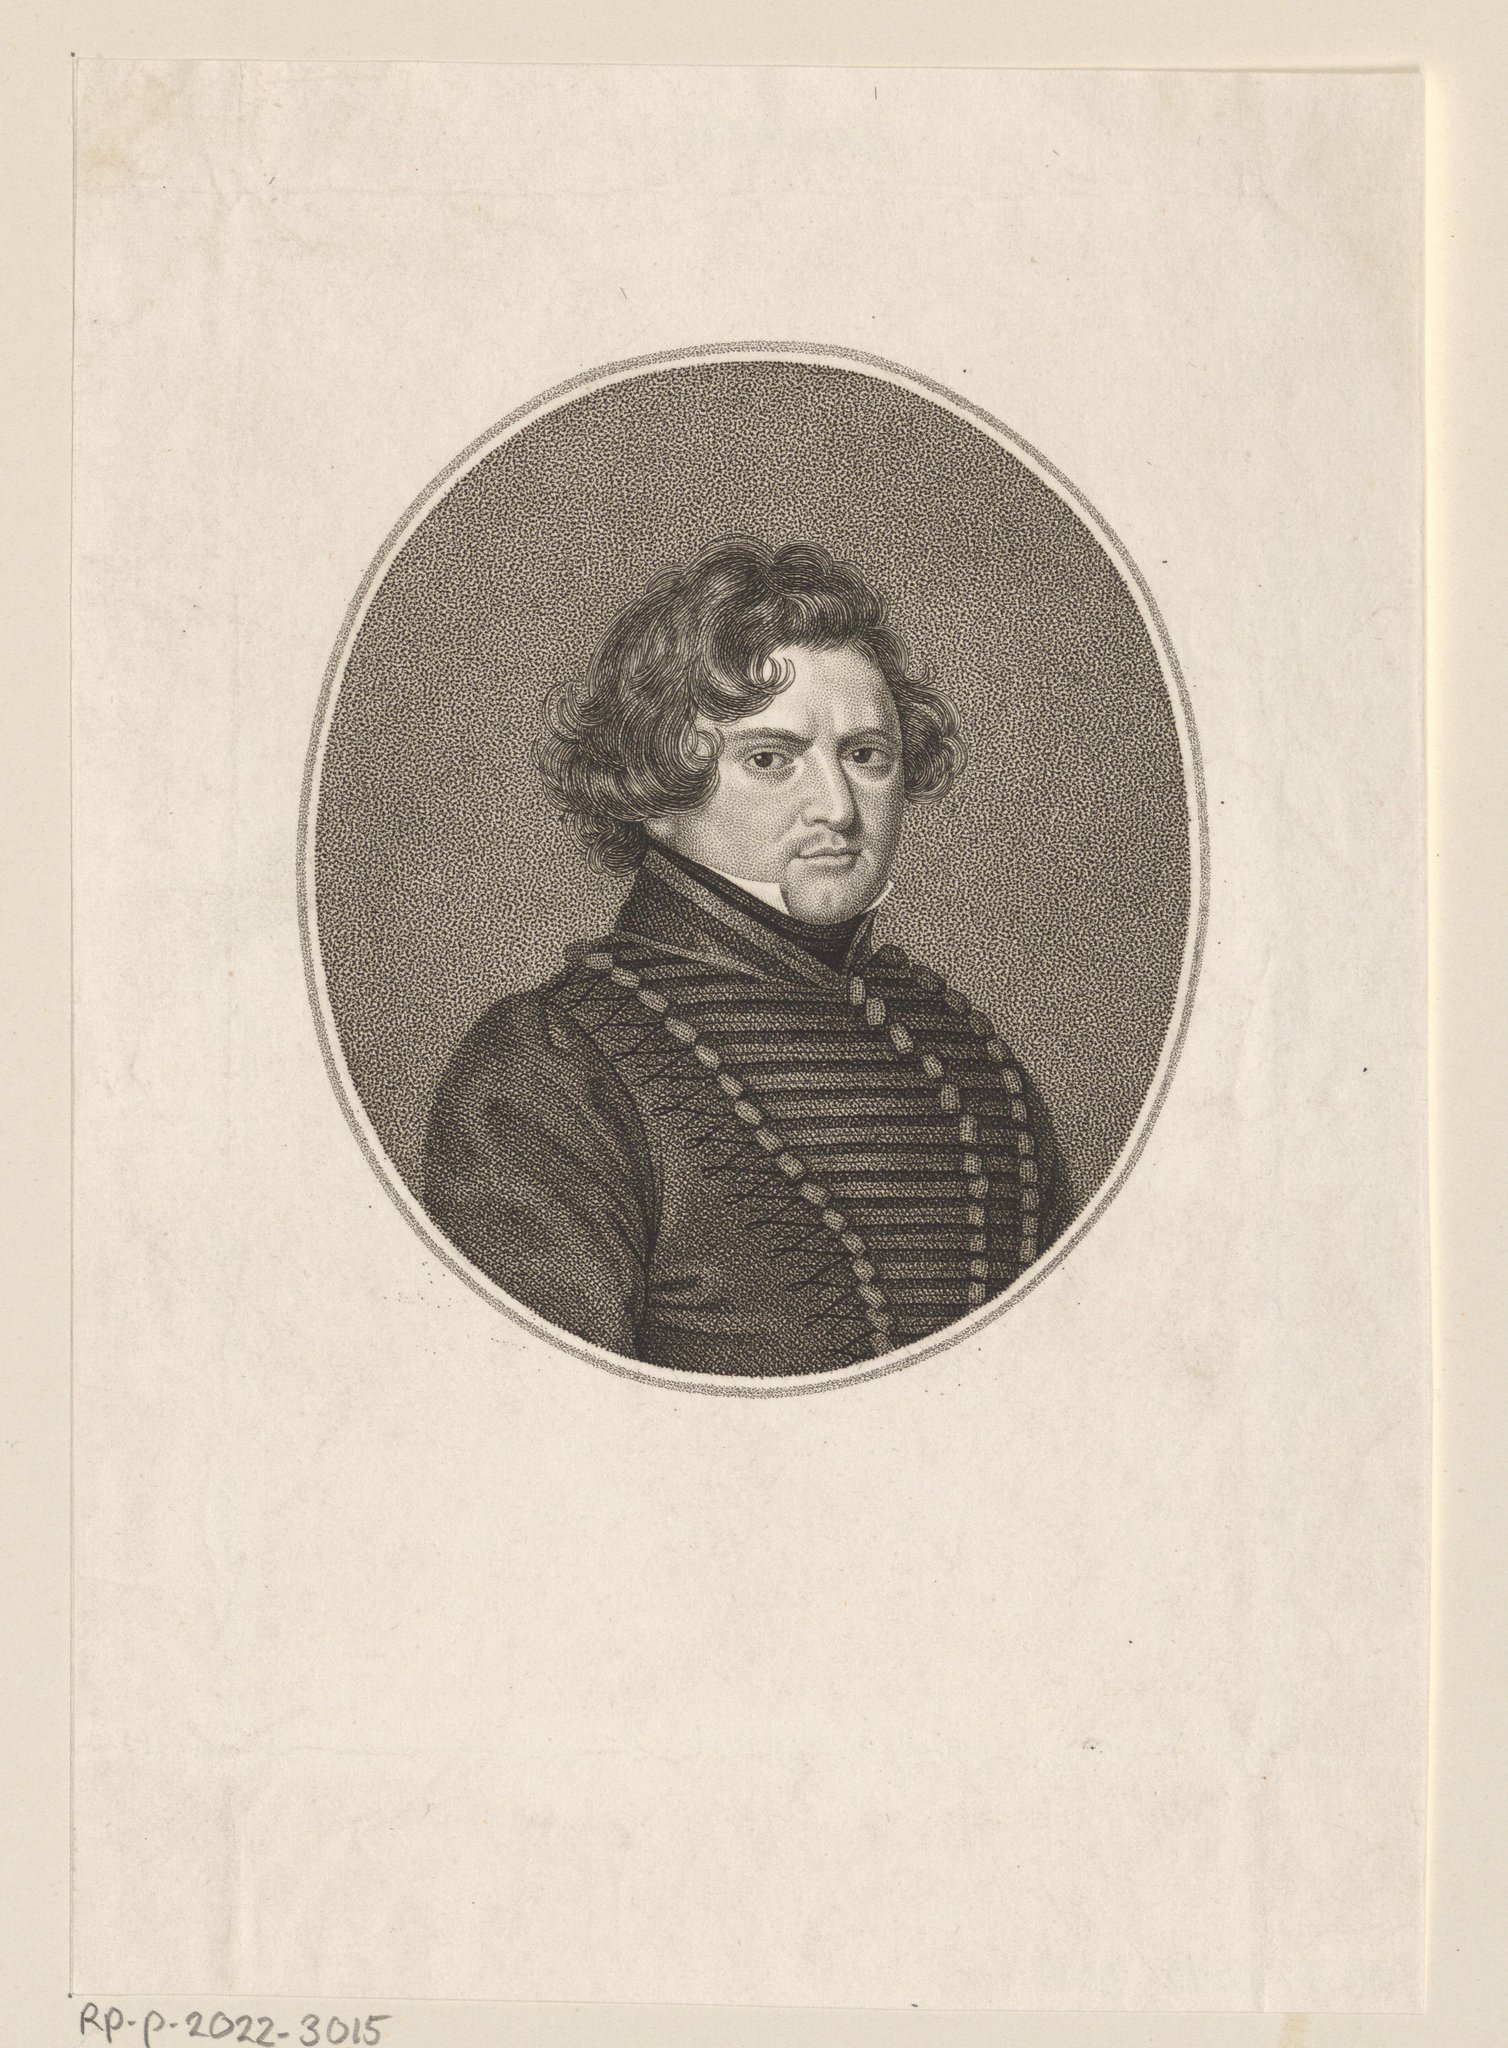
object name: print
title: Portret van Karl Spindler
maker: pieter van der meulen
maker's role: draughtsman, painter, print maker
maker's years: 1780-1858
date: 1826-1858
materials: paper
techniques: etching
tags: historical persons, portrait of a writer